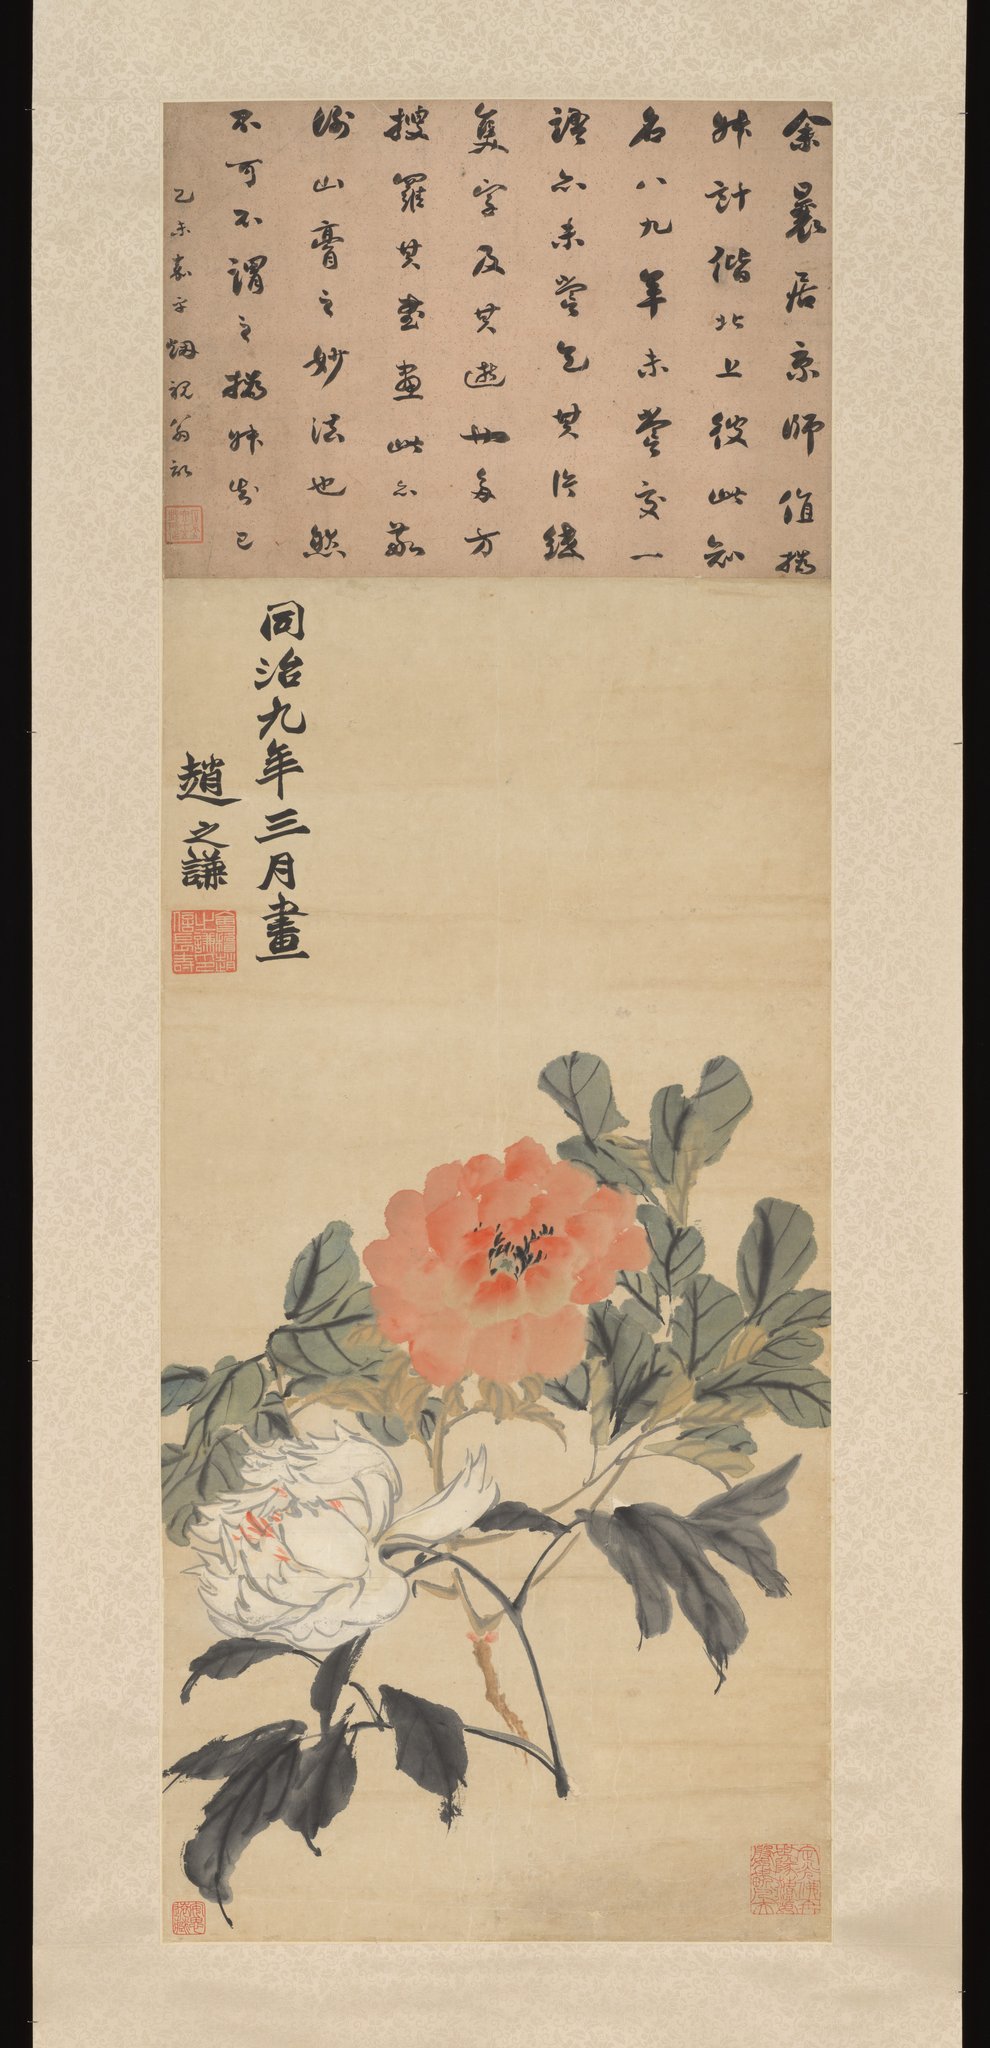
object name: hanging scroll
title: Peonies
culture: chinese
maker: zhao zhiqian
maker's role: artist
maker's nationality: chinese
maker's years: 1829-1884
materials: ink, paper